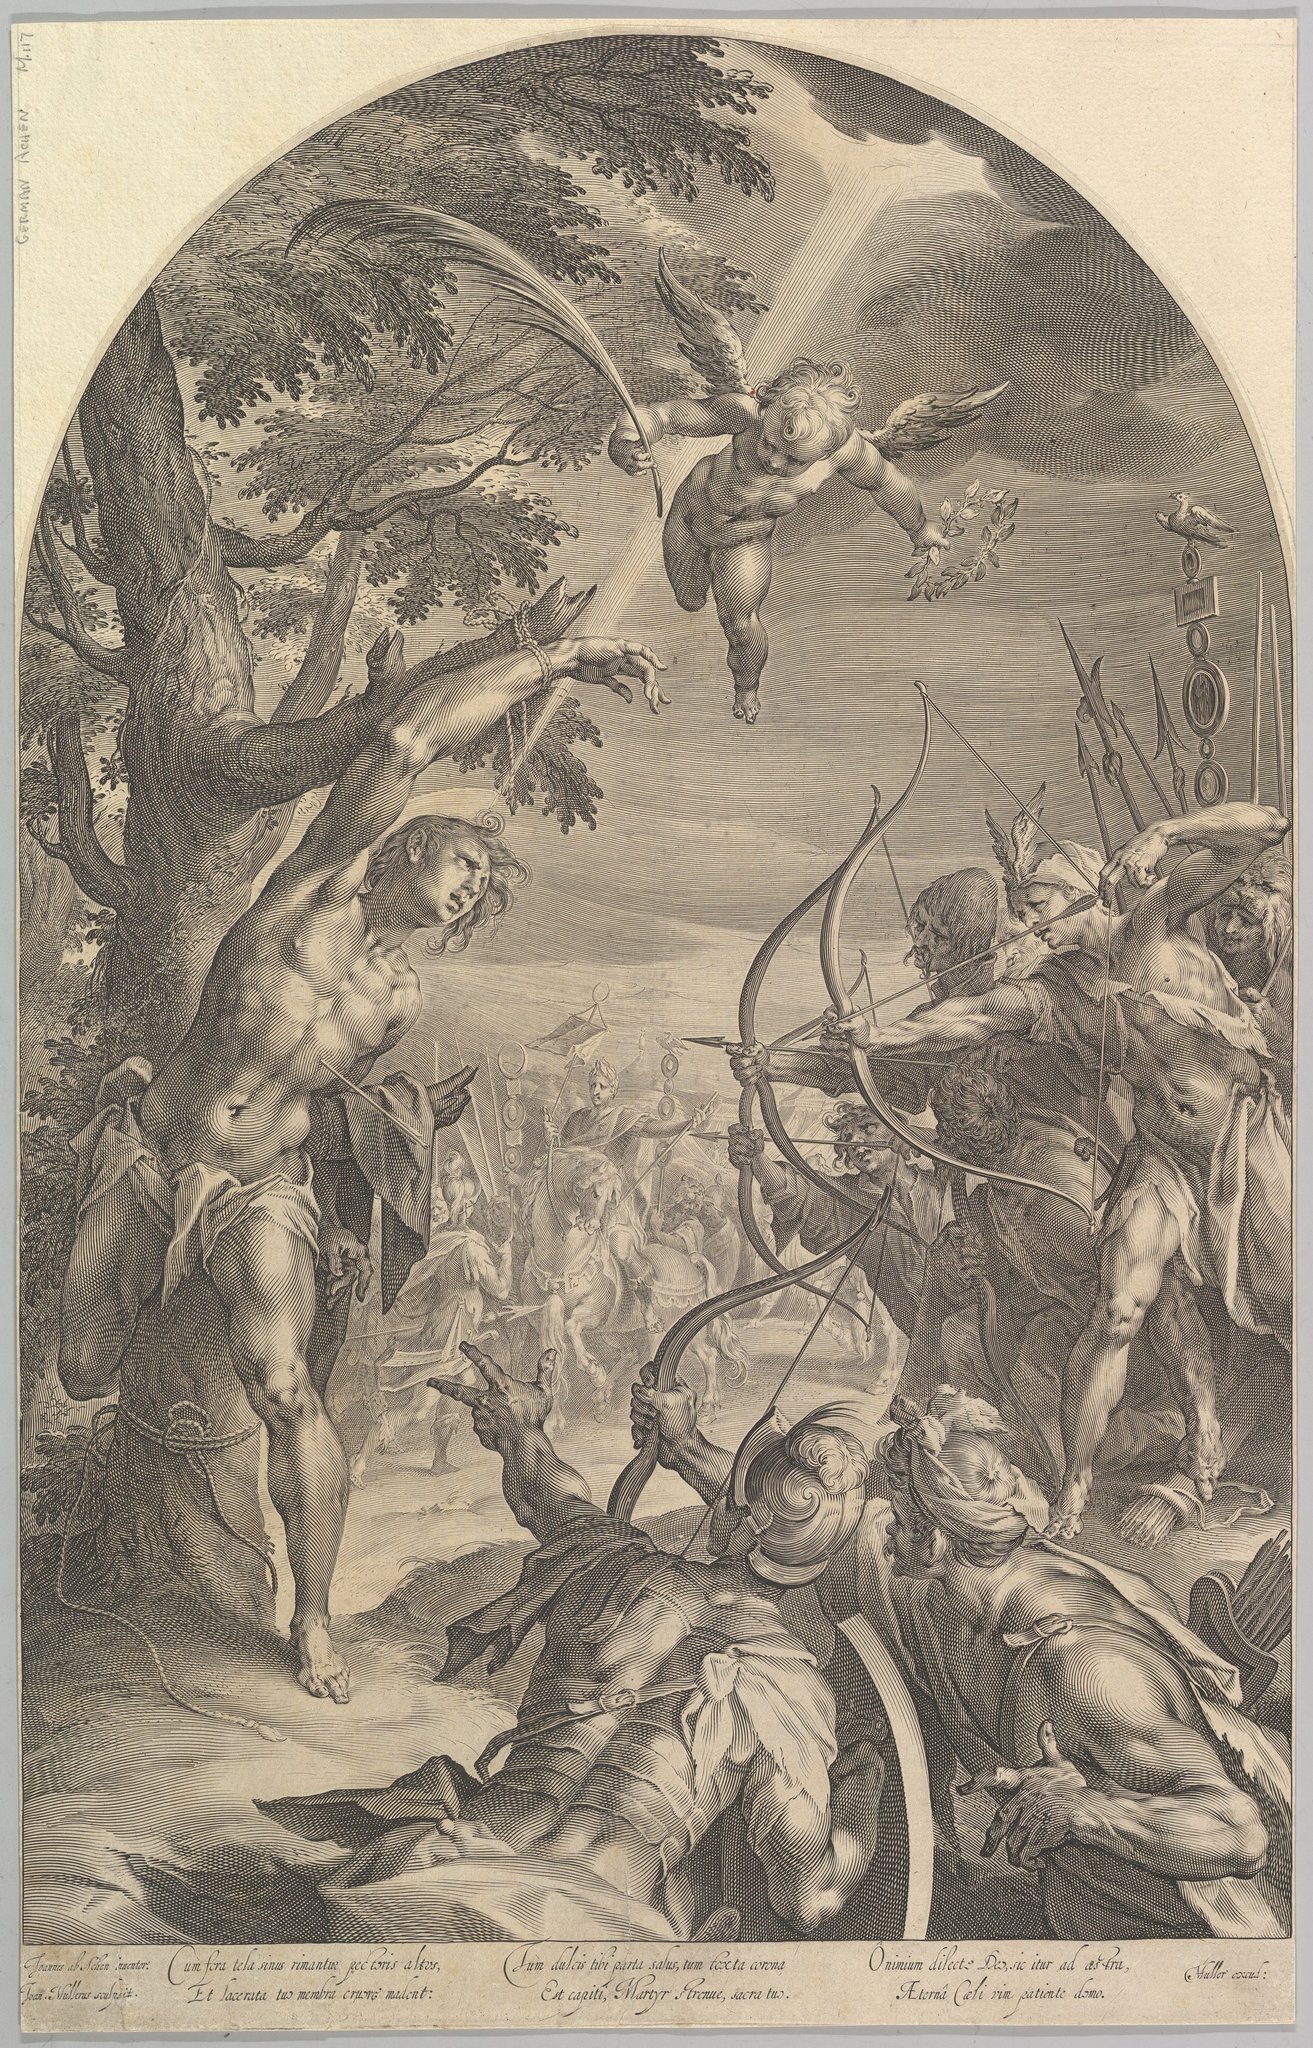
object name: print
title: The Martyrdom of St. Sebastian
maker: jan muller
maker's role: artist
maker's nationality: netherlandish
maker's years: 1571-1628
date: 1600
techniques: engraving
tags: bow and arrow,men,putti,saints